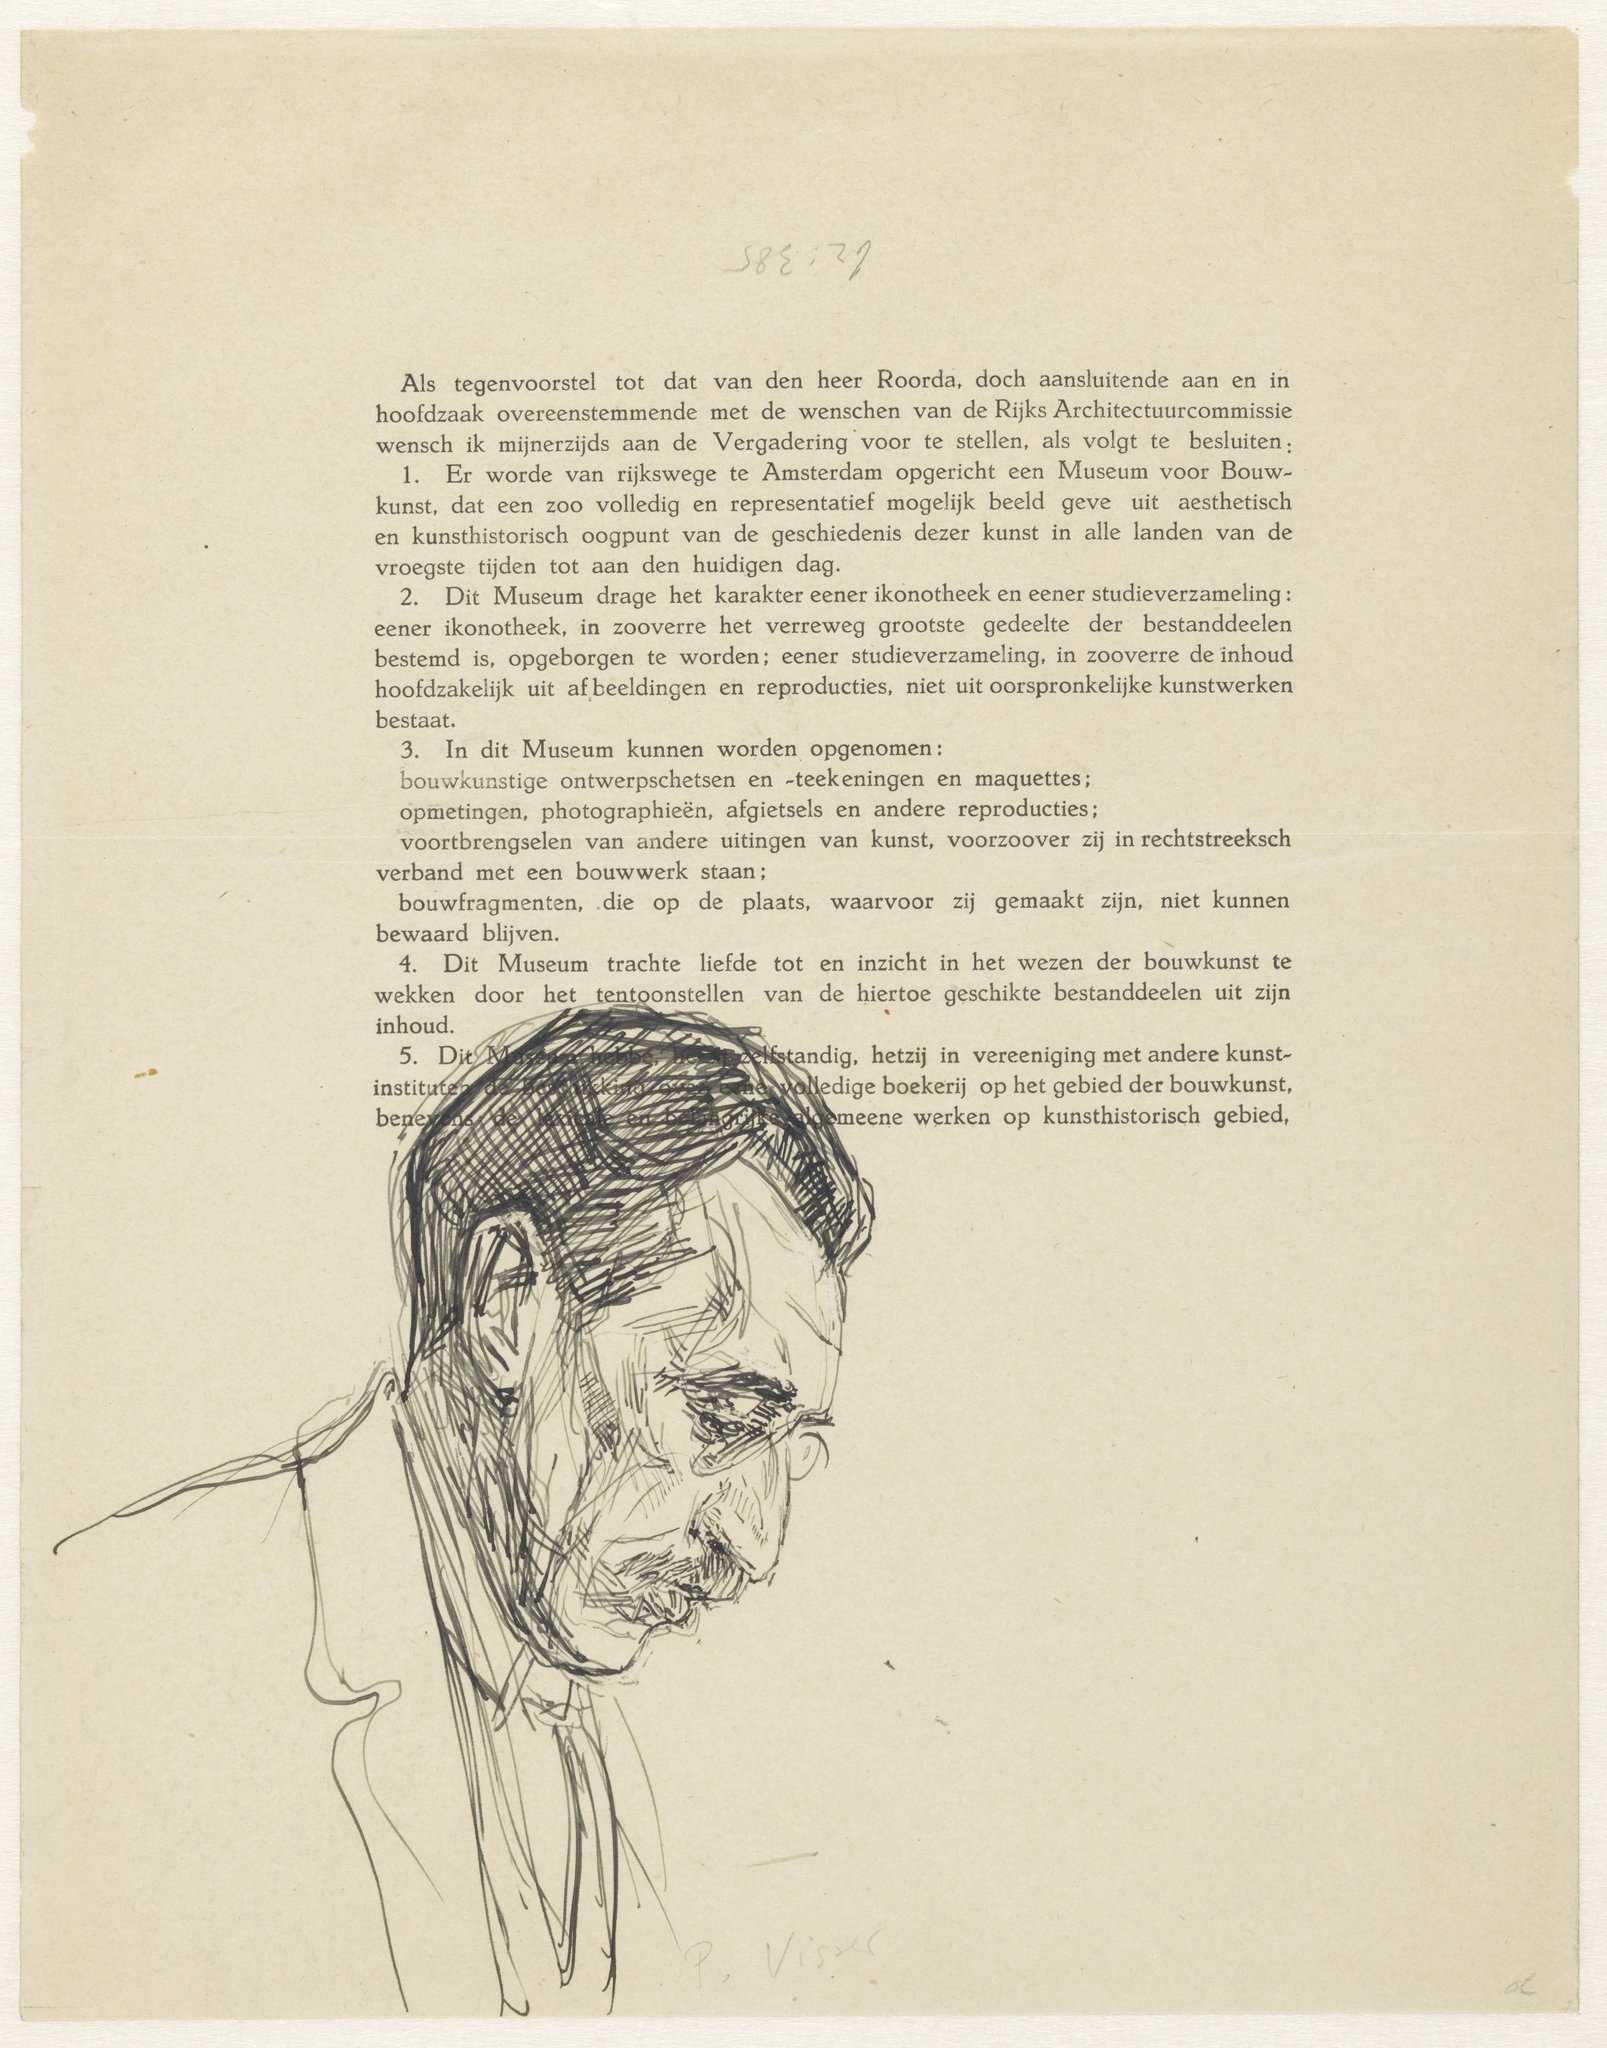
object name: drawing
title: Portret van P. Visser, profiel naar rechts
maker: jan veth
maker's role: designer, draughtsman, painter, print maker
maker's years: 1864-1925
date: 1874-1925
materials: ink, paper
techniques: pen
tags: piet visser, historical persons